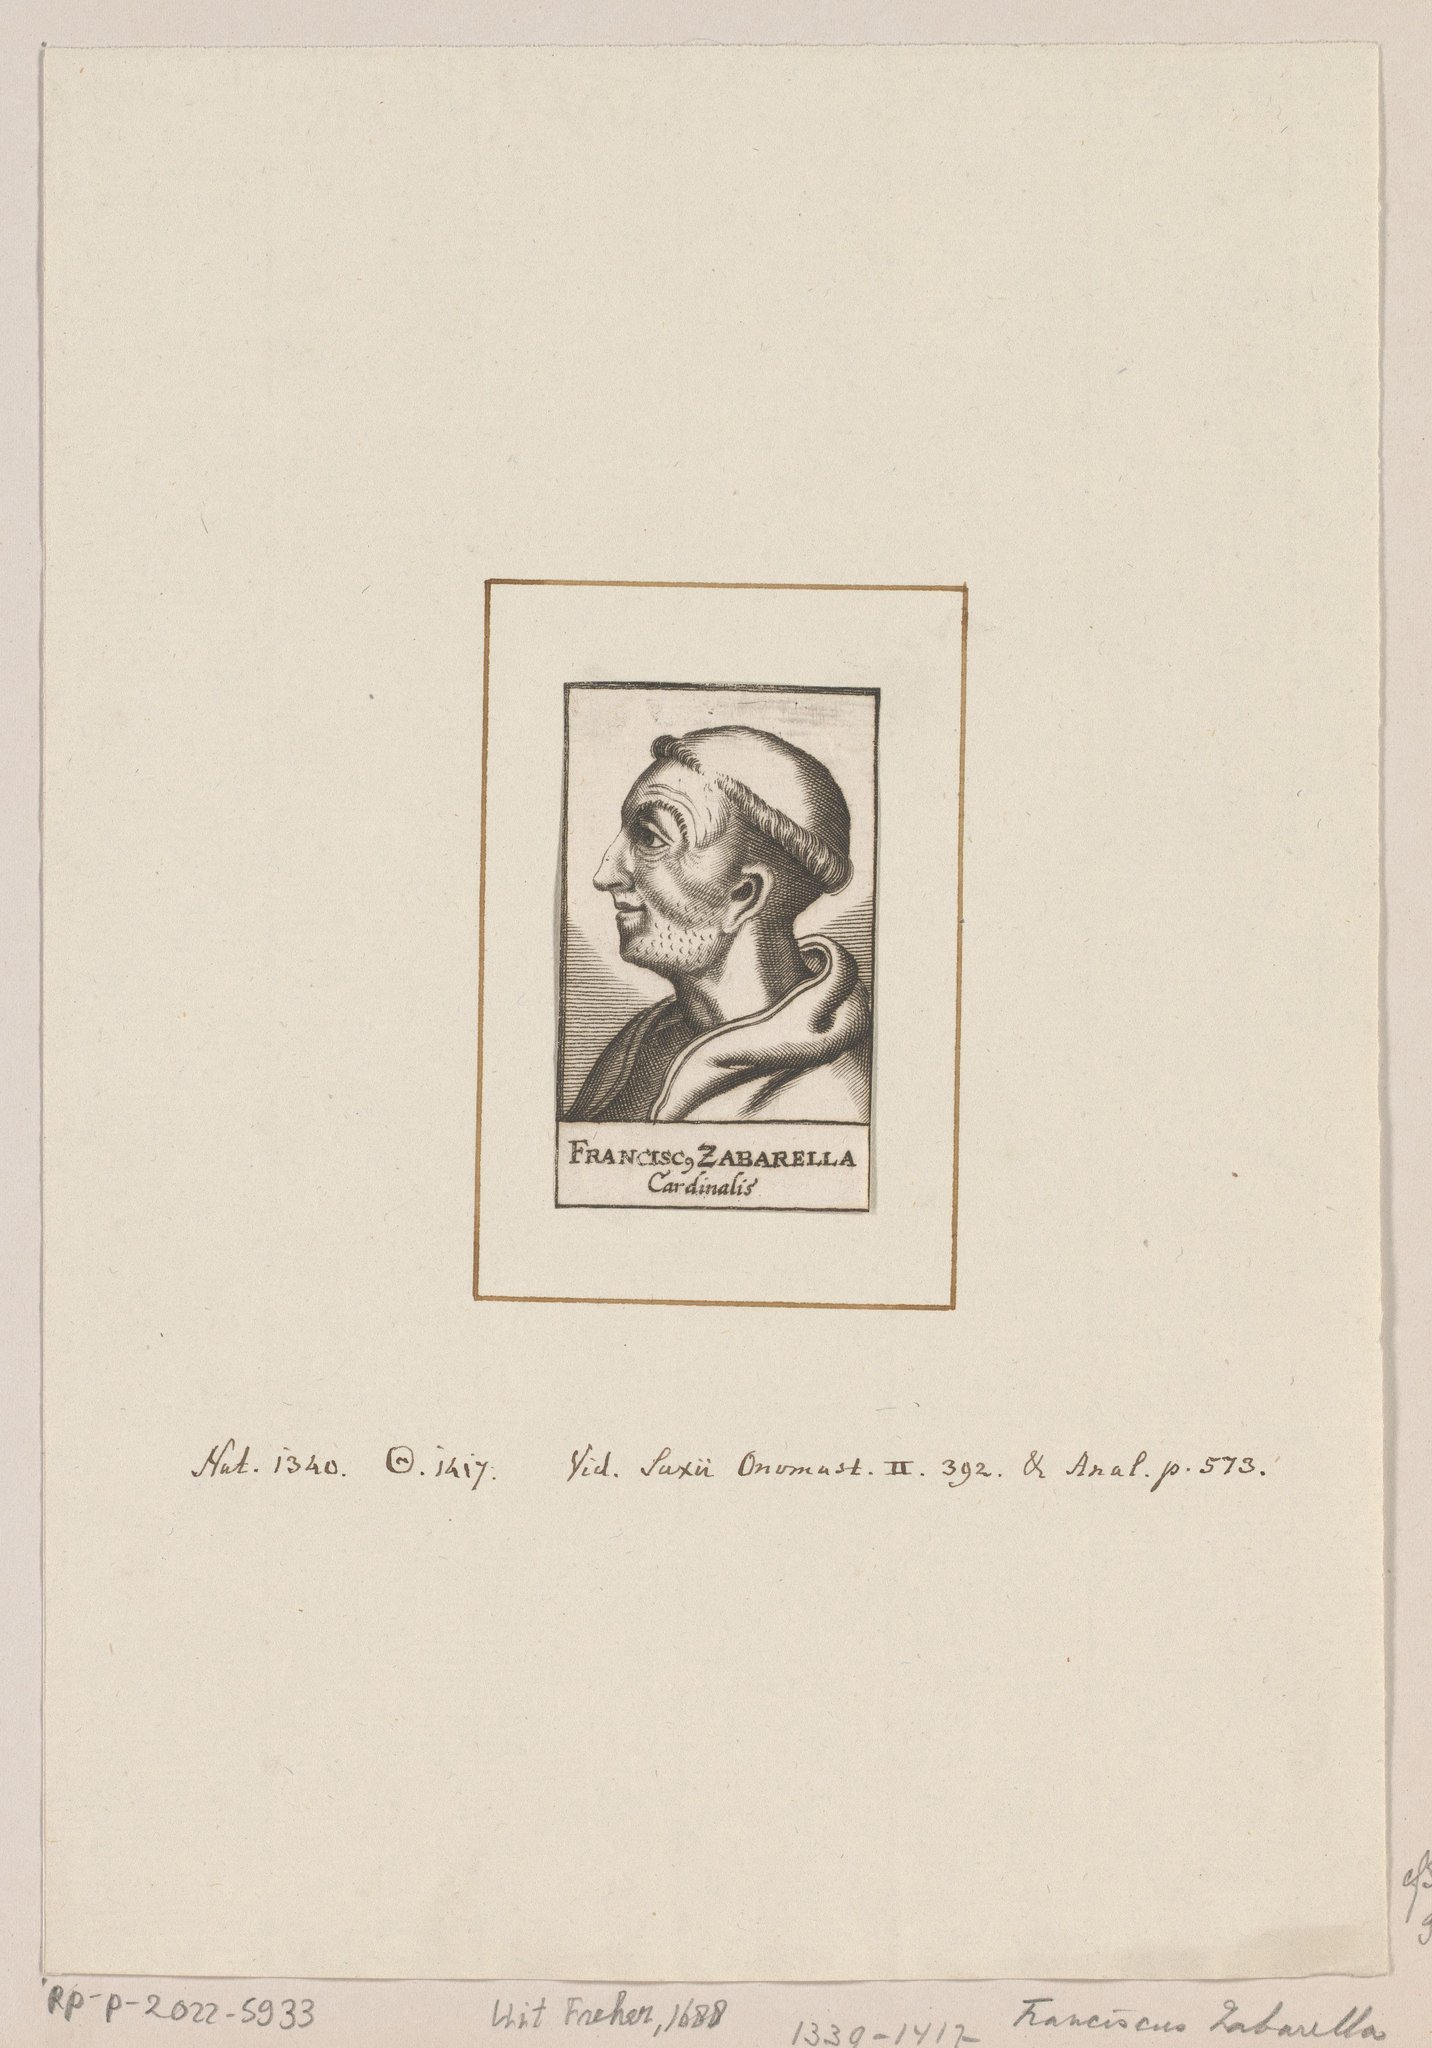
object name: print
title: Portret van Francesco Zabarella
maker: Anonymous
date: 1688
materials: paper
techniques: engraving, etching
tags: clergyman, cardinal, historical persons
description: Prent waarschijnlijk uit: Freher, Paul. Theatrum virorum eruditione clarorum. Neurenberg: Johann Hoffmann, 1688, dl. 1.